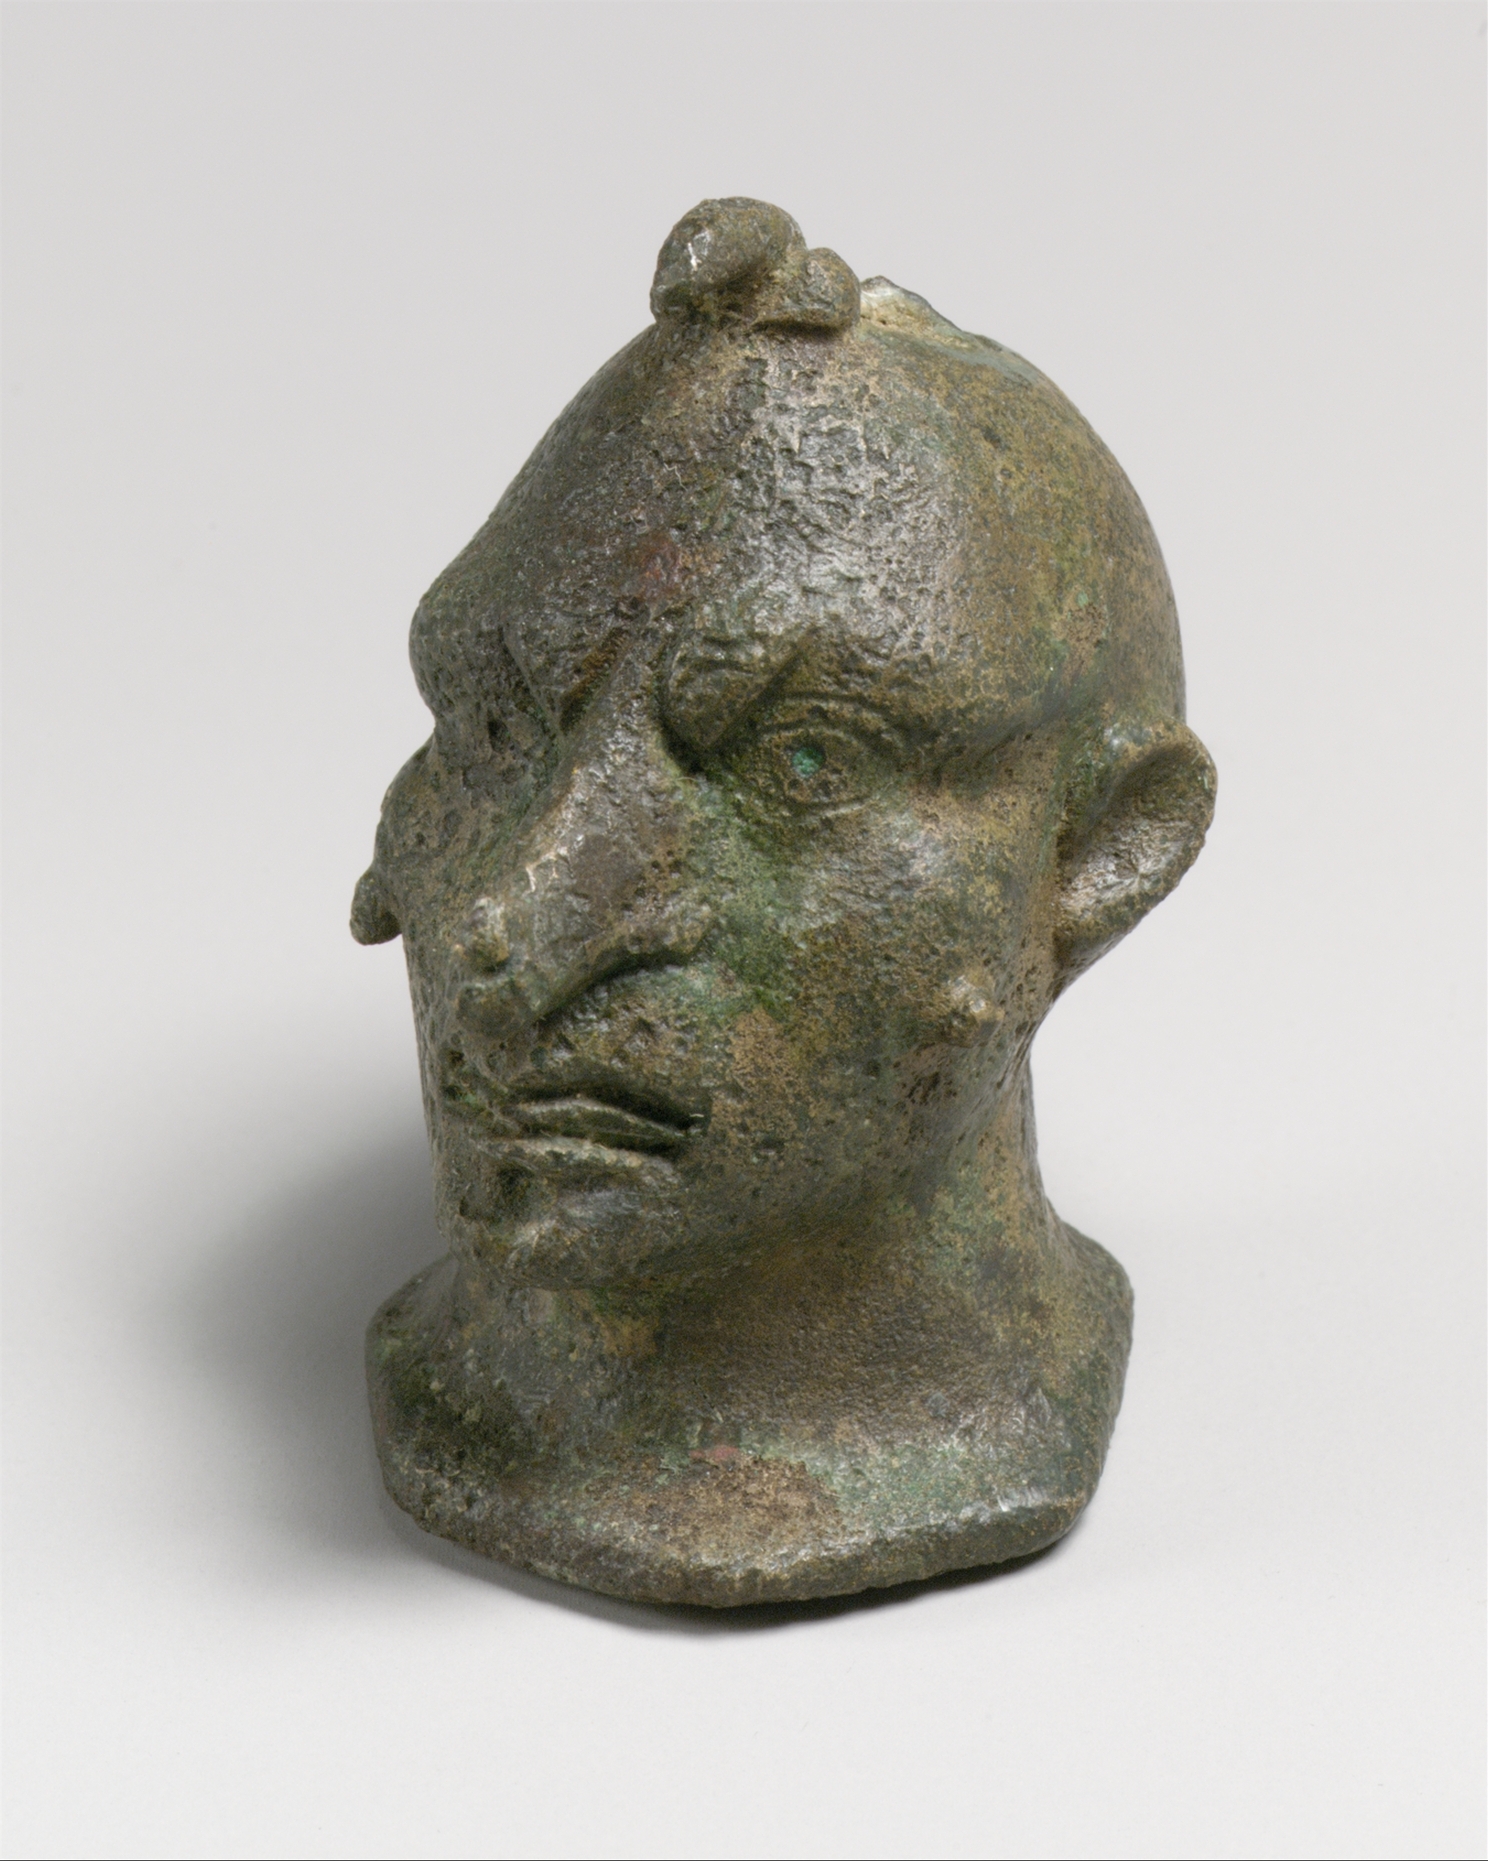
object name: head of a man, grotesque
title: Bronze head of a grotesque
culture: roman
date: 1-200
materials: bronze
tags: heads,men